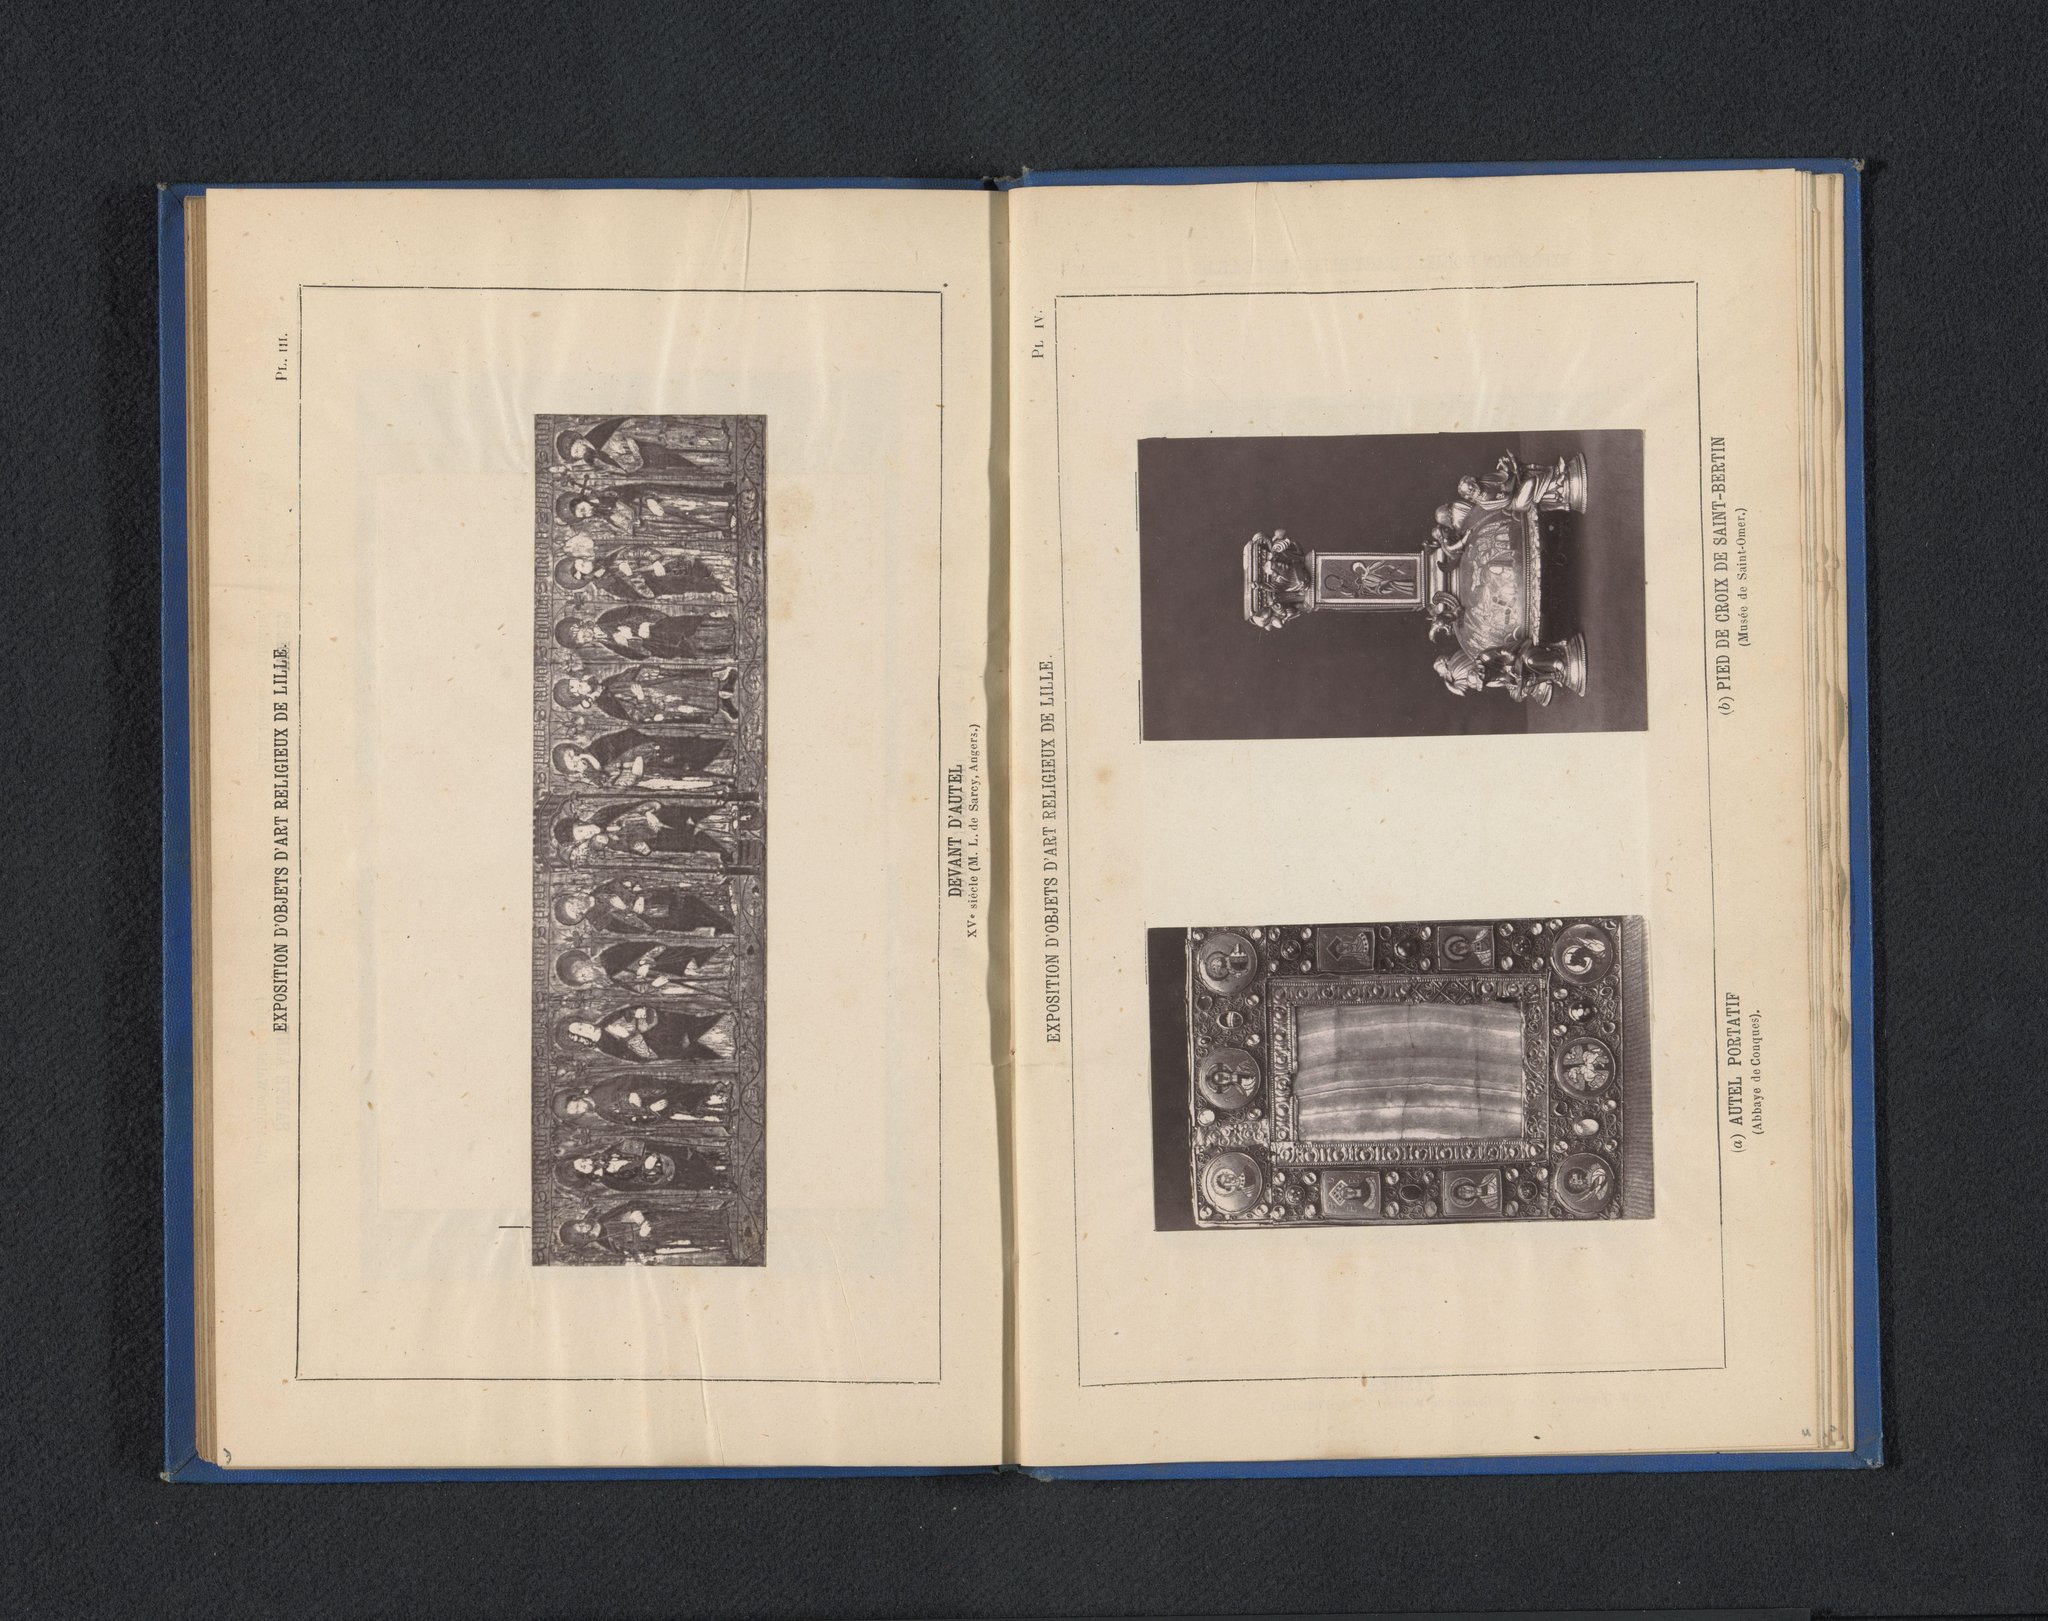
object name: page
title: Sainte Anne, Ivoires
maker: Anonymous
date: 1871-1876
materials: cardboard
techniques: woodburytype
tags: saints, altar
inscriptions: inscription: ‘Exposition d'objets d'art religieux de Lille’, inscription: ‘XVe siècle (M.L. de Sarcy, Angers)’, inscription: ‘Pl. III.’